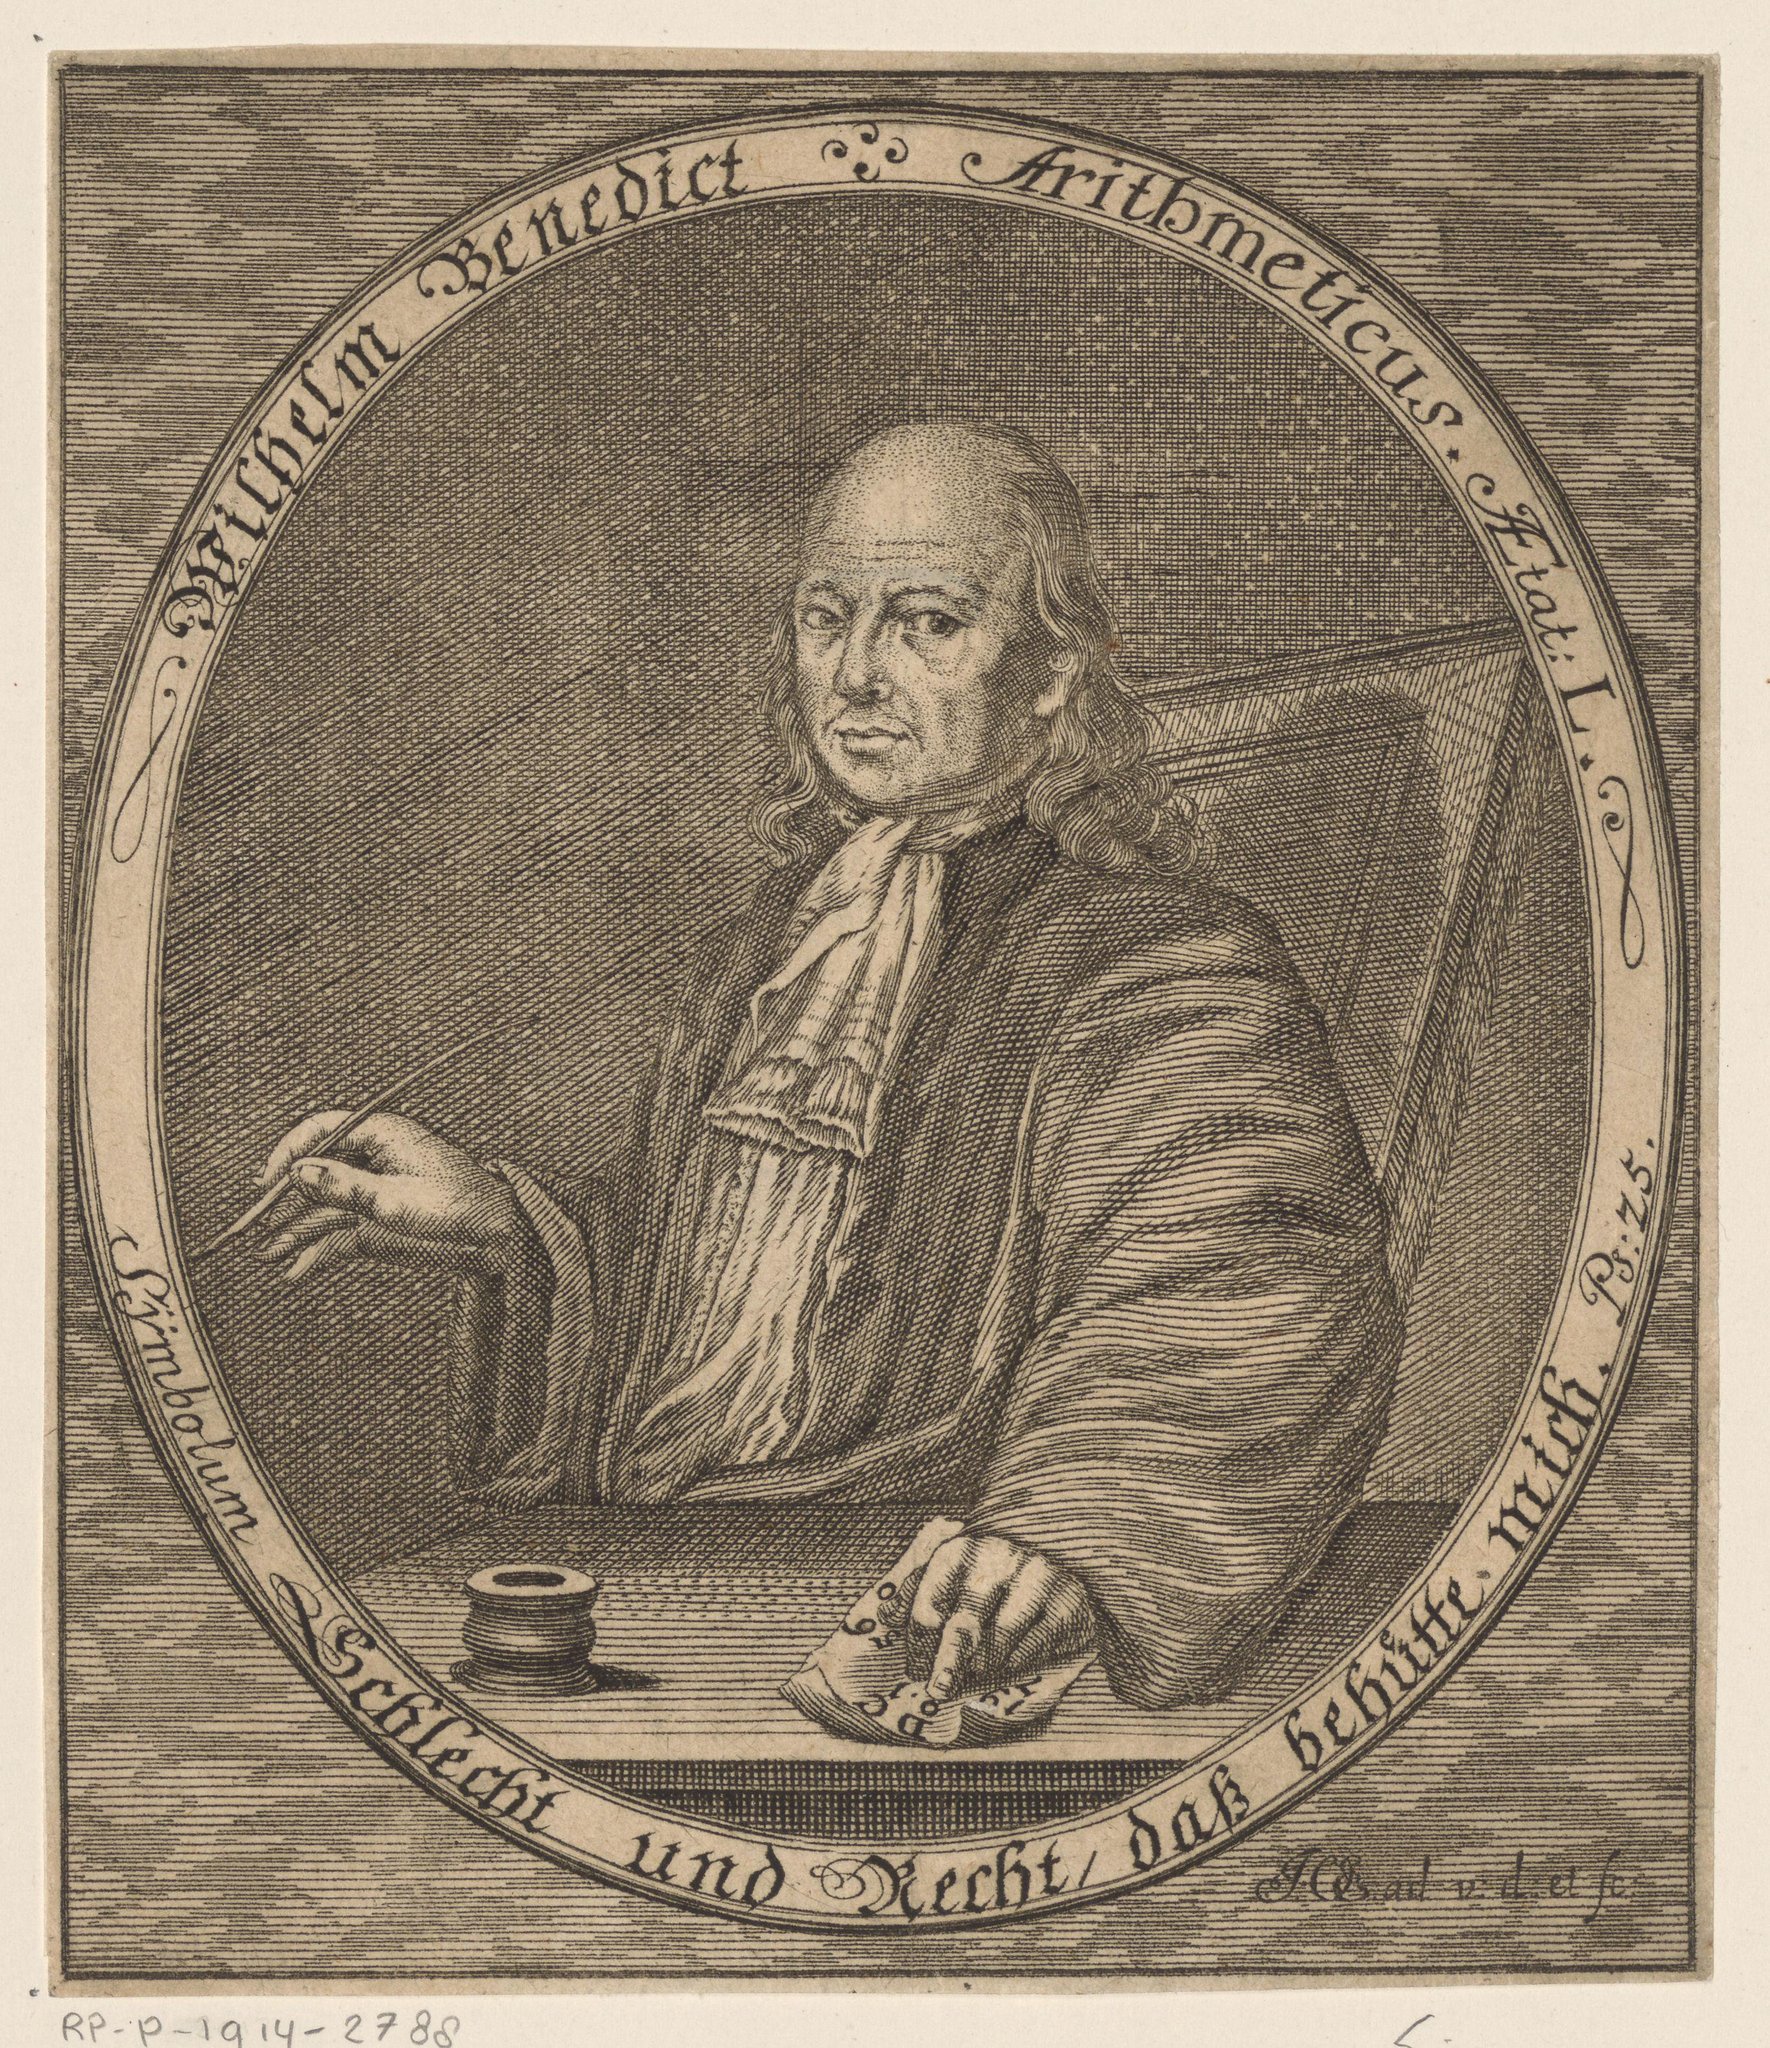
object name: print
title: Portret van Wilhelm Benedict op 50-jarige leeftijd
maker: johann oertl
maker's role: print maker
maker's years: 1690-1718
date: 1688-1718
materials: paper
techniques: engraving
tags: historical persons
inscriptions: collector's mark: Lugt 2228